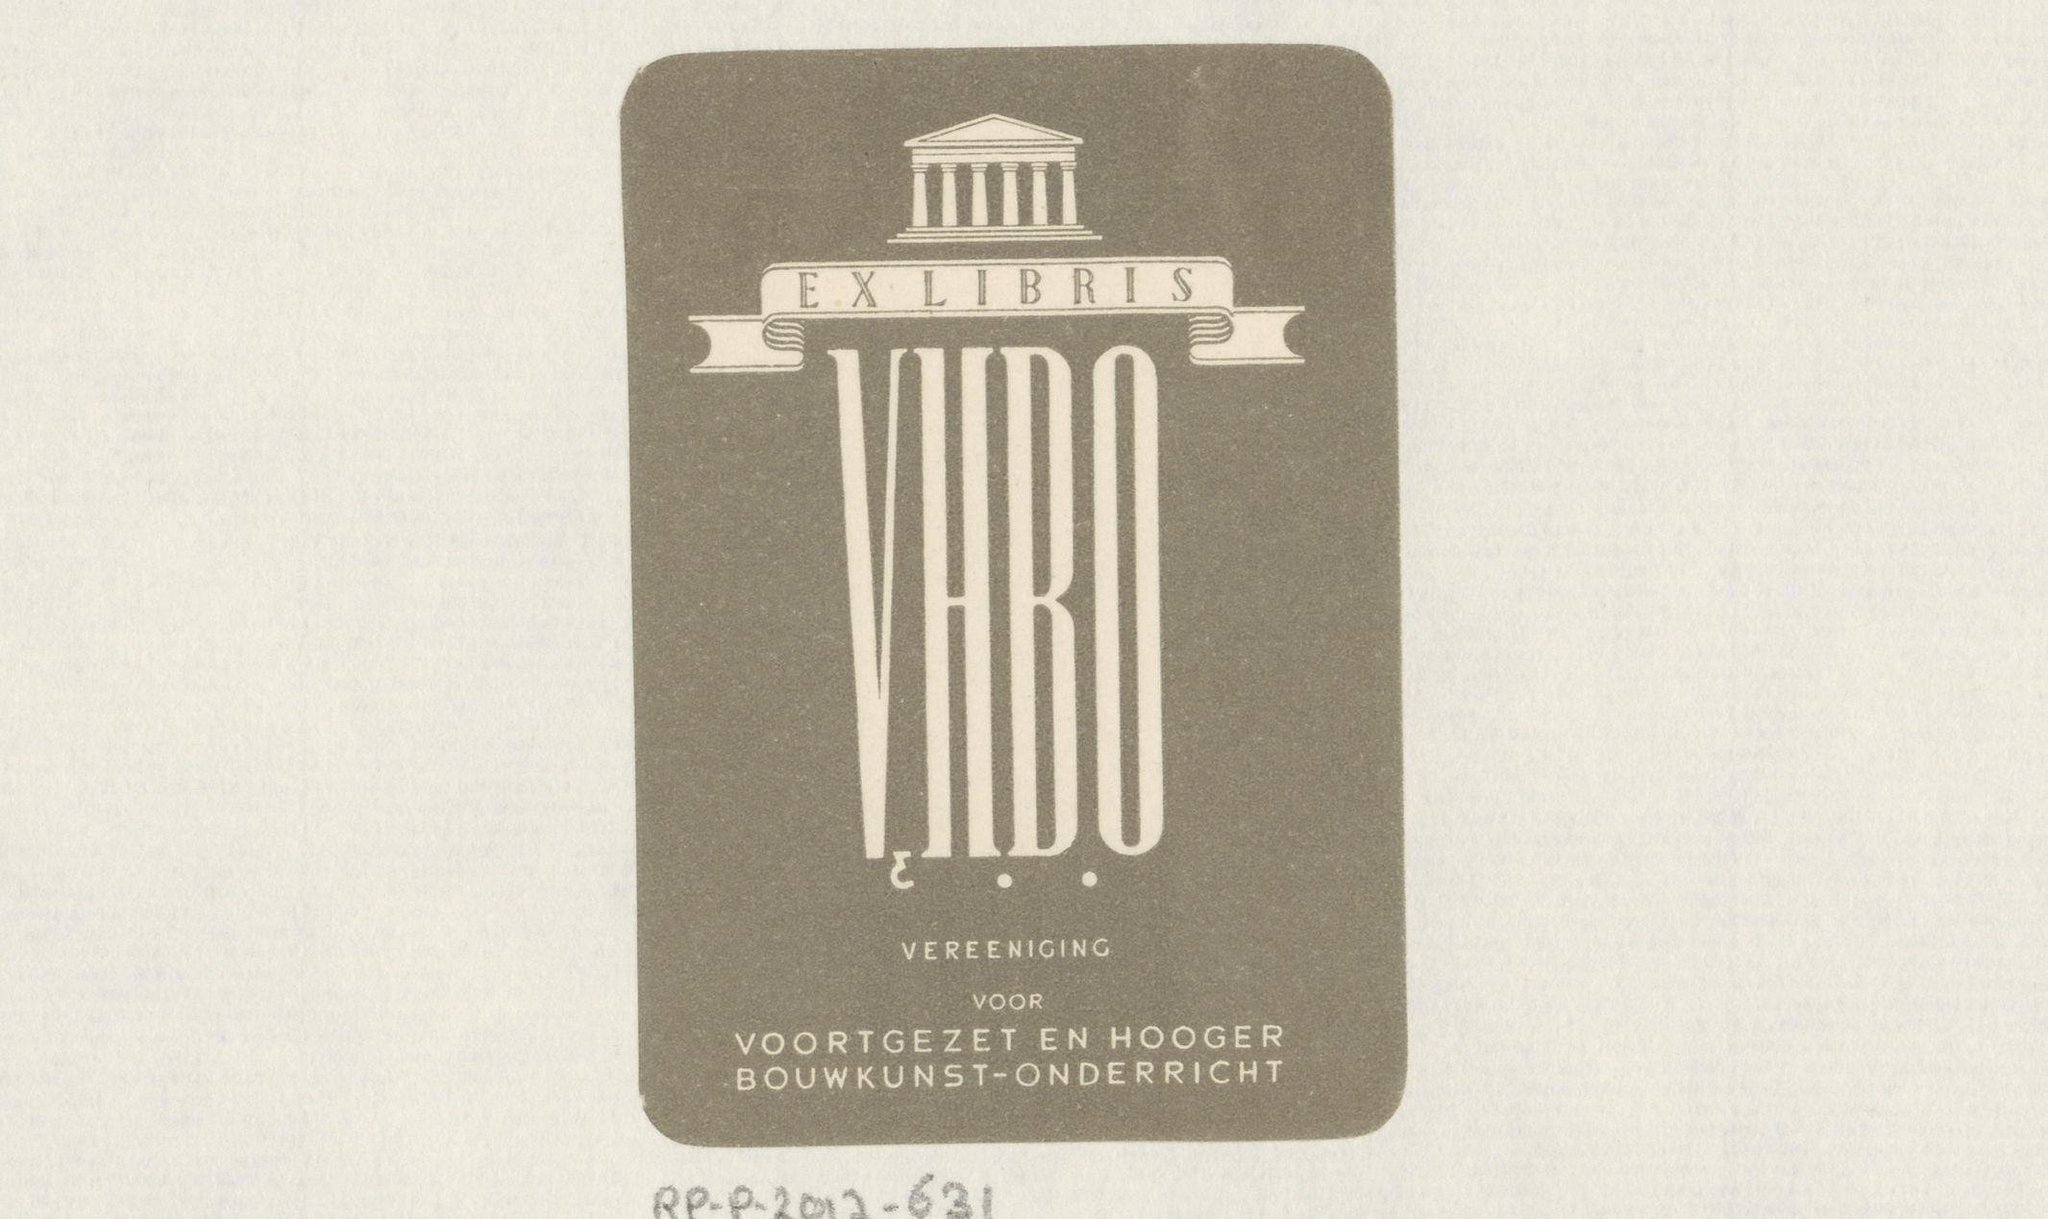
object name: bookplate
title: Ex libris van de Vereeniging voor voortgezet en hooger bouwkunst-onderricht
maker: Anonymous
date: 1908-1987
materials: paper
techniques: printing block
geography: netherlands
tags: temple, shrine ~ greek religion